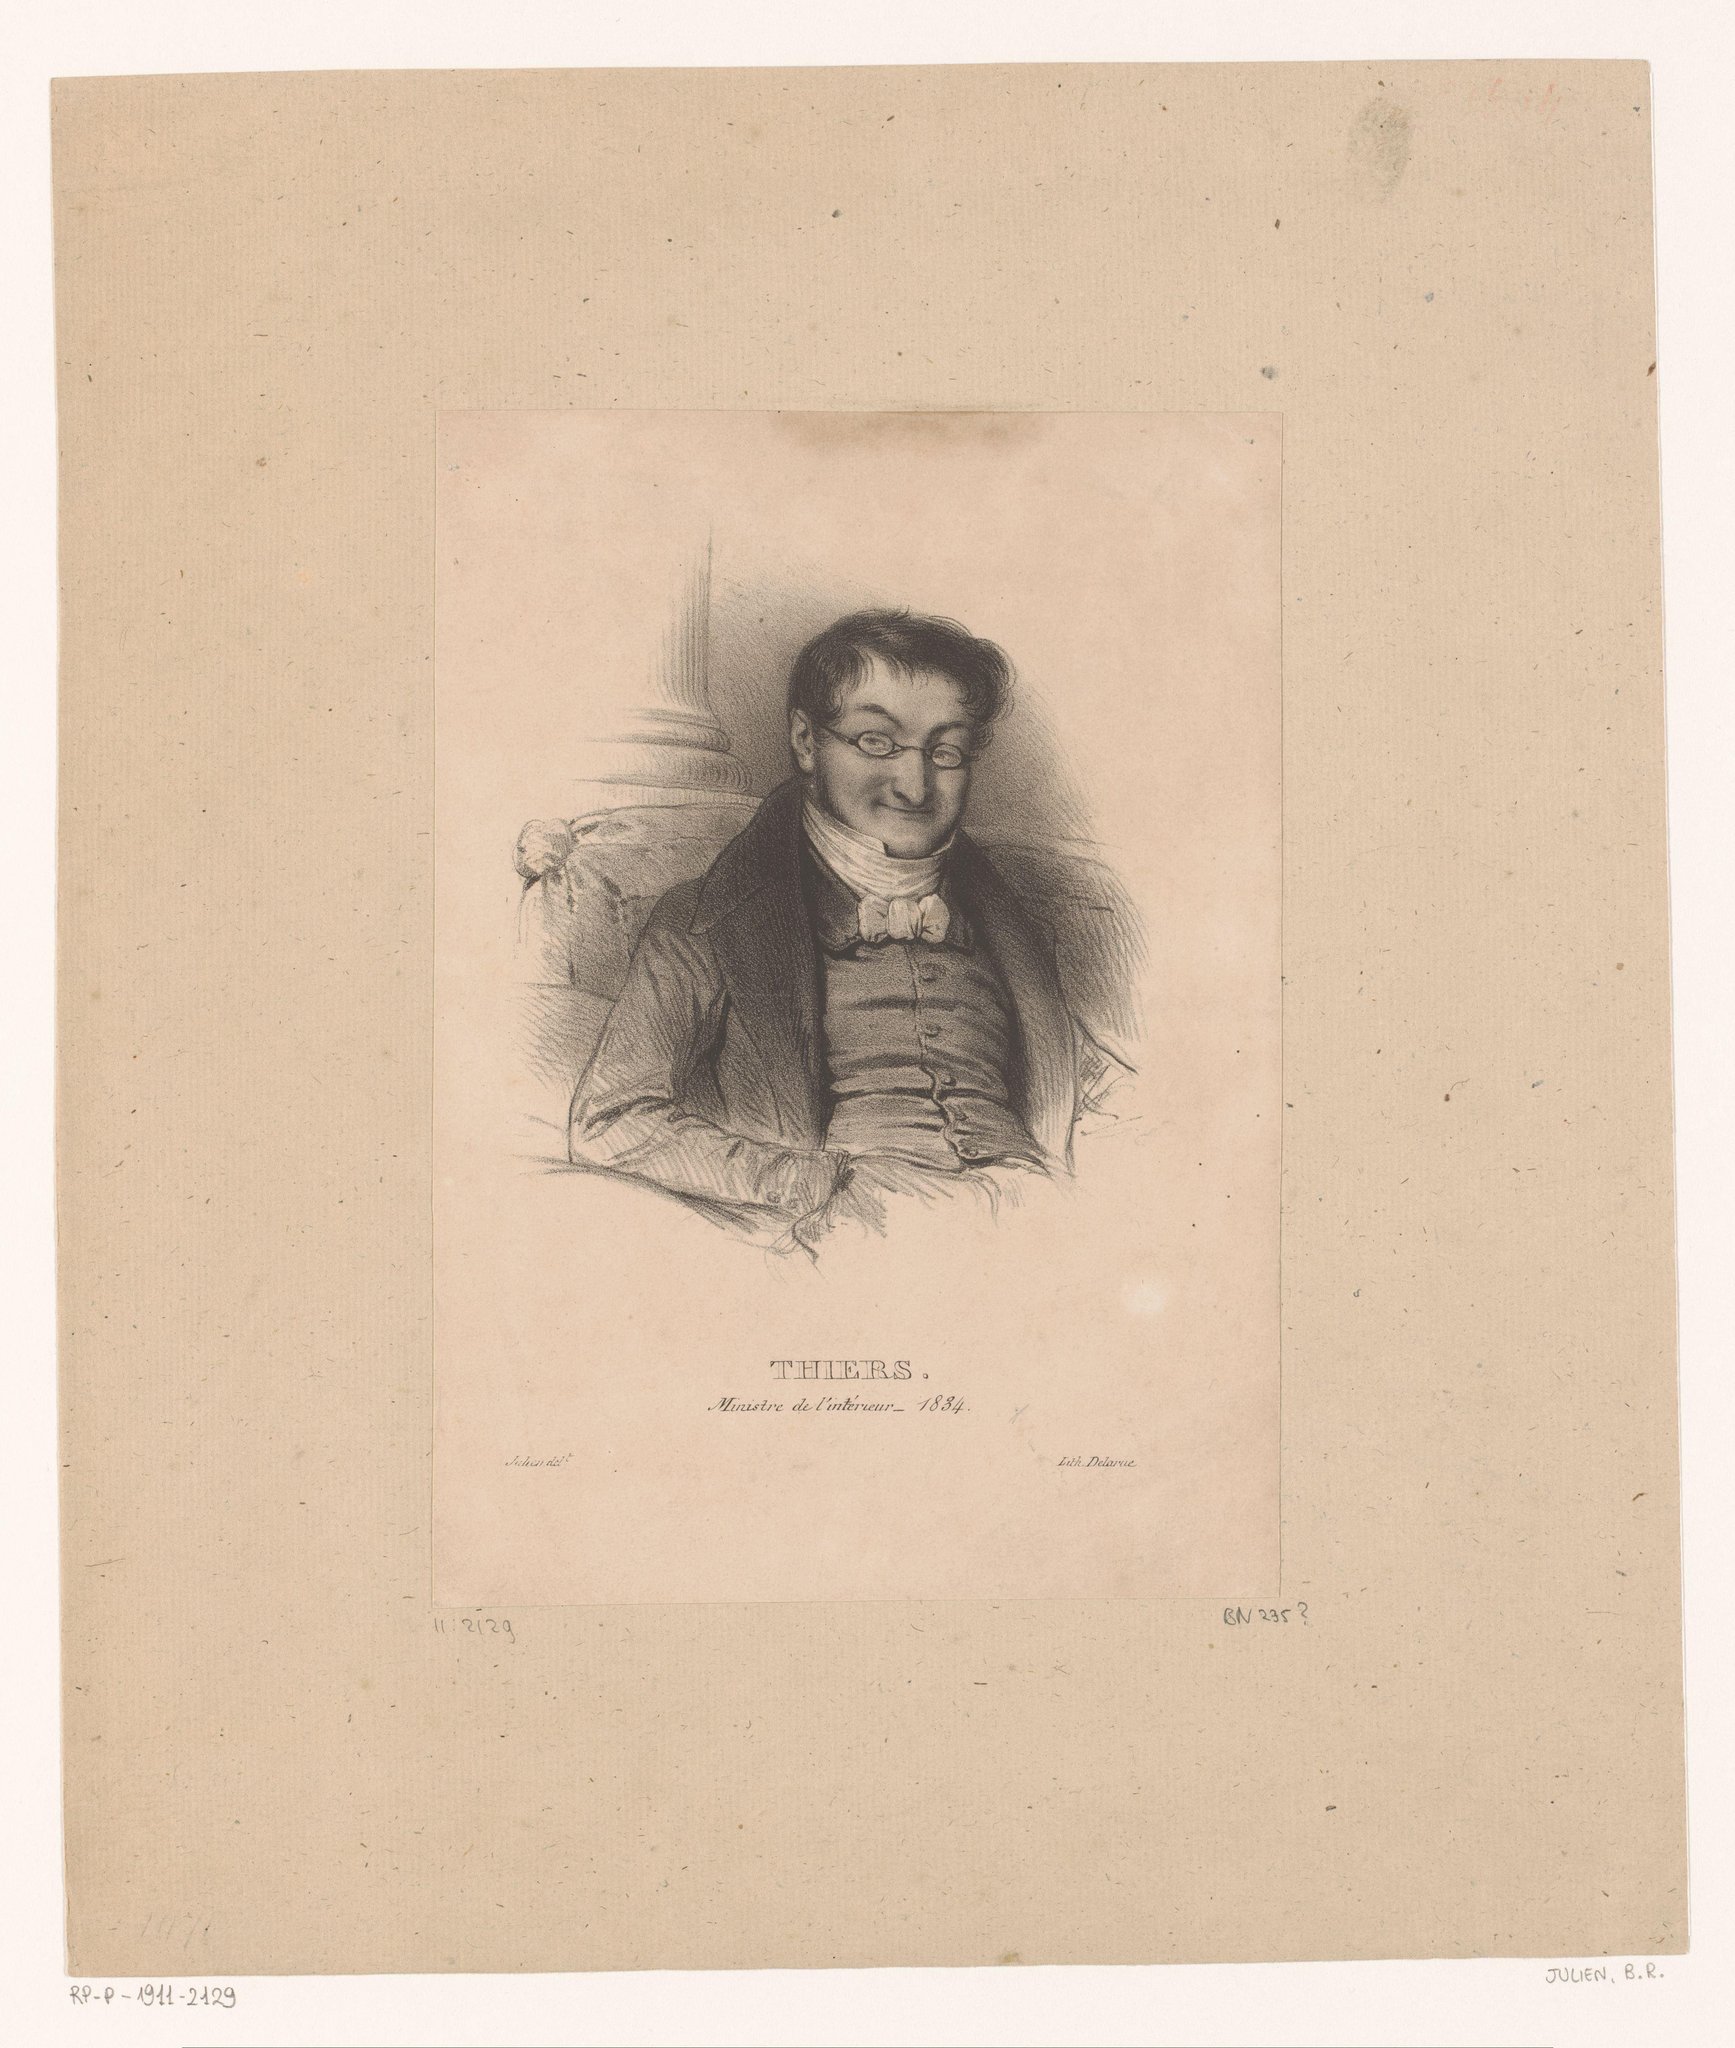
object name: print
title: Thiers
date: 1834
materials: paper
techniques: lithograph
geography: paris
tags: marseille, politician, historical persons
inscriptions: collector's mark: Lugt 2228a